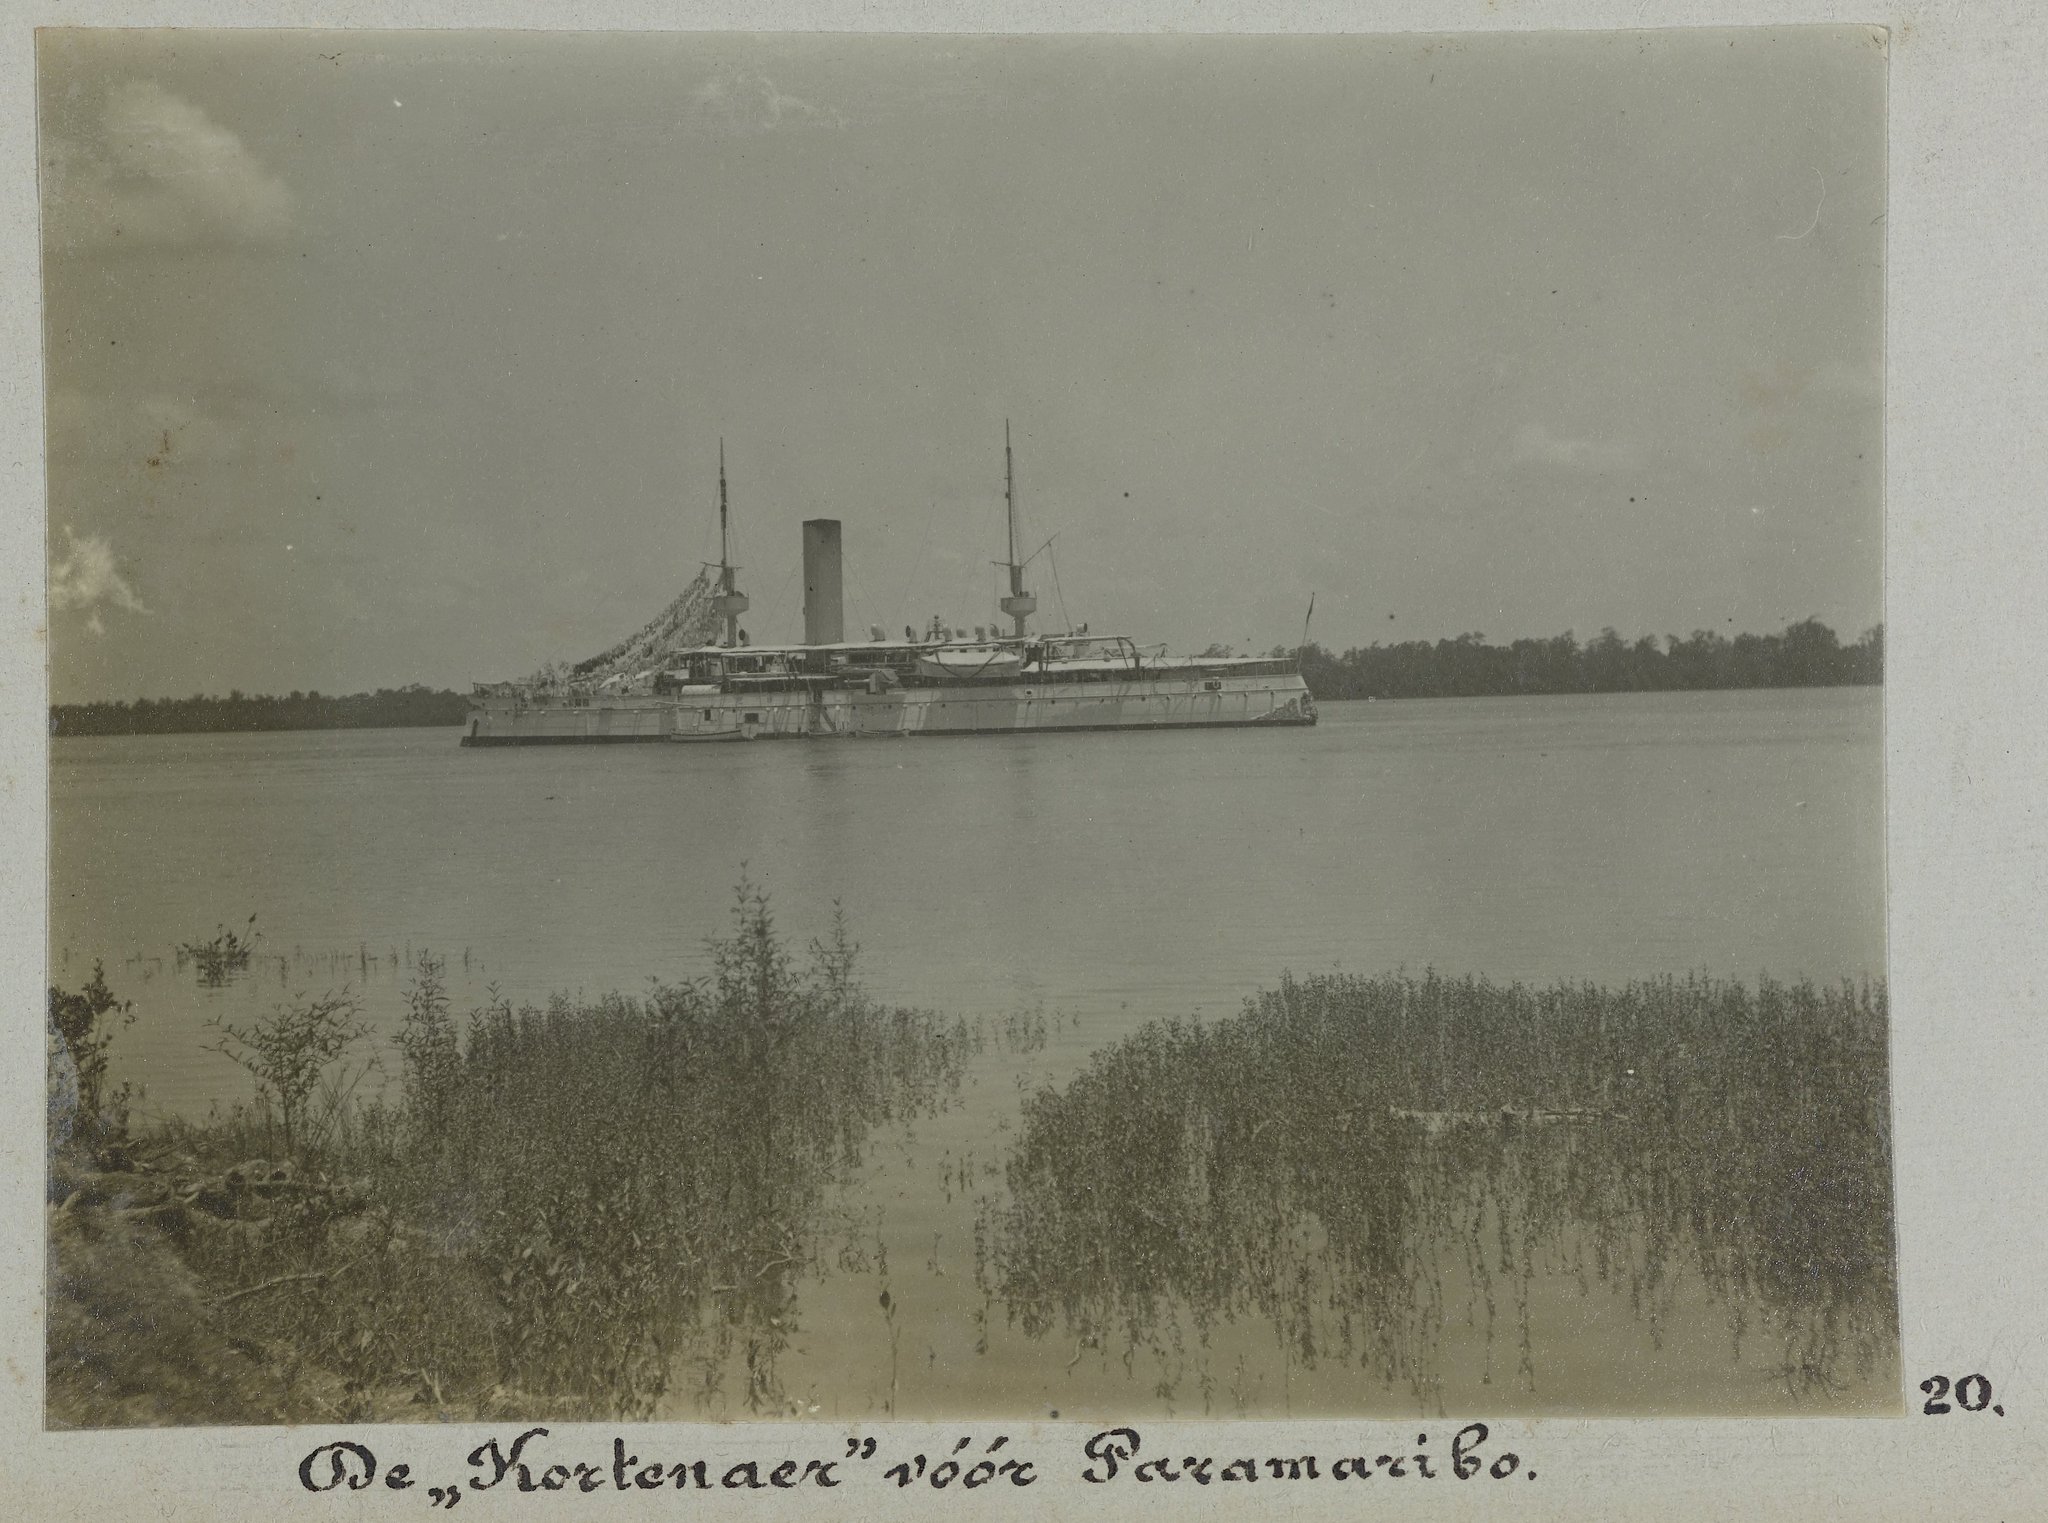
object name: photograph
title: De "Kortenaer" vóór Paramaribo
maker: hendrik doijer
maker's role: engineer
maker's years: 1863-1925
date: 1903-1910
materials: photographic support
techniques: gelatin silver print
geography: suriname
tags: suriname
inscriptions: inscription: ‘20. / De "Kortenaer" vóór Paramaribo.’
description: Het pantserschip de Kortenaer liggend voor de rede van Paramaribo. Onderdeel van het fotoalbum Souvenir de Voyage (deel 1), over het leven van de familie Doijer in en rond de plantage Ma Retraite in Suriname in de jaren 1903-1910.